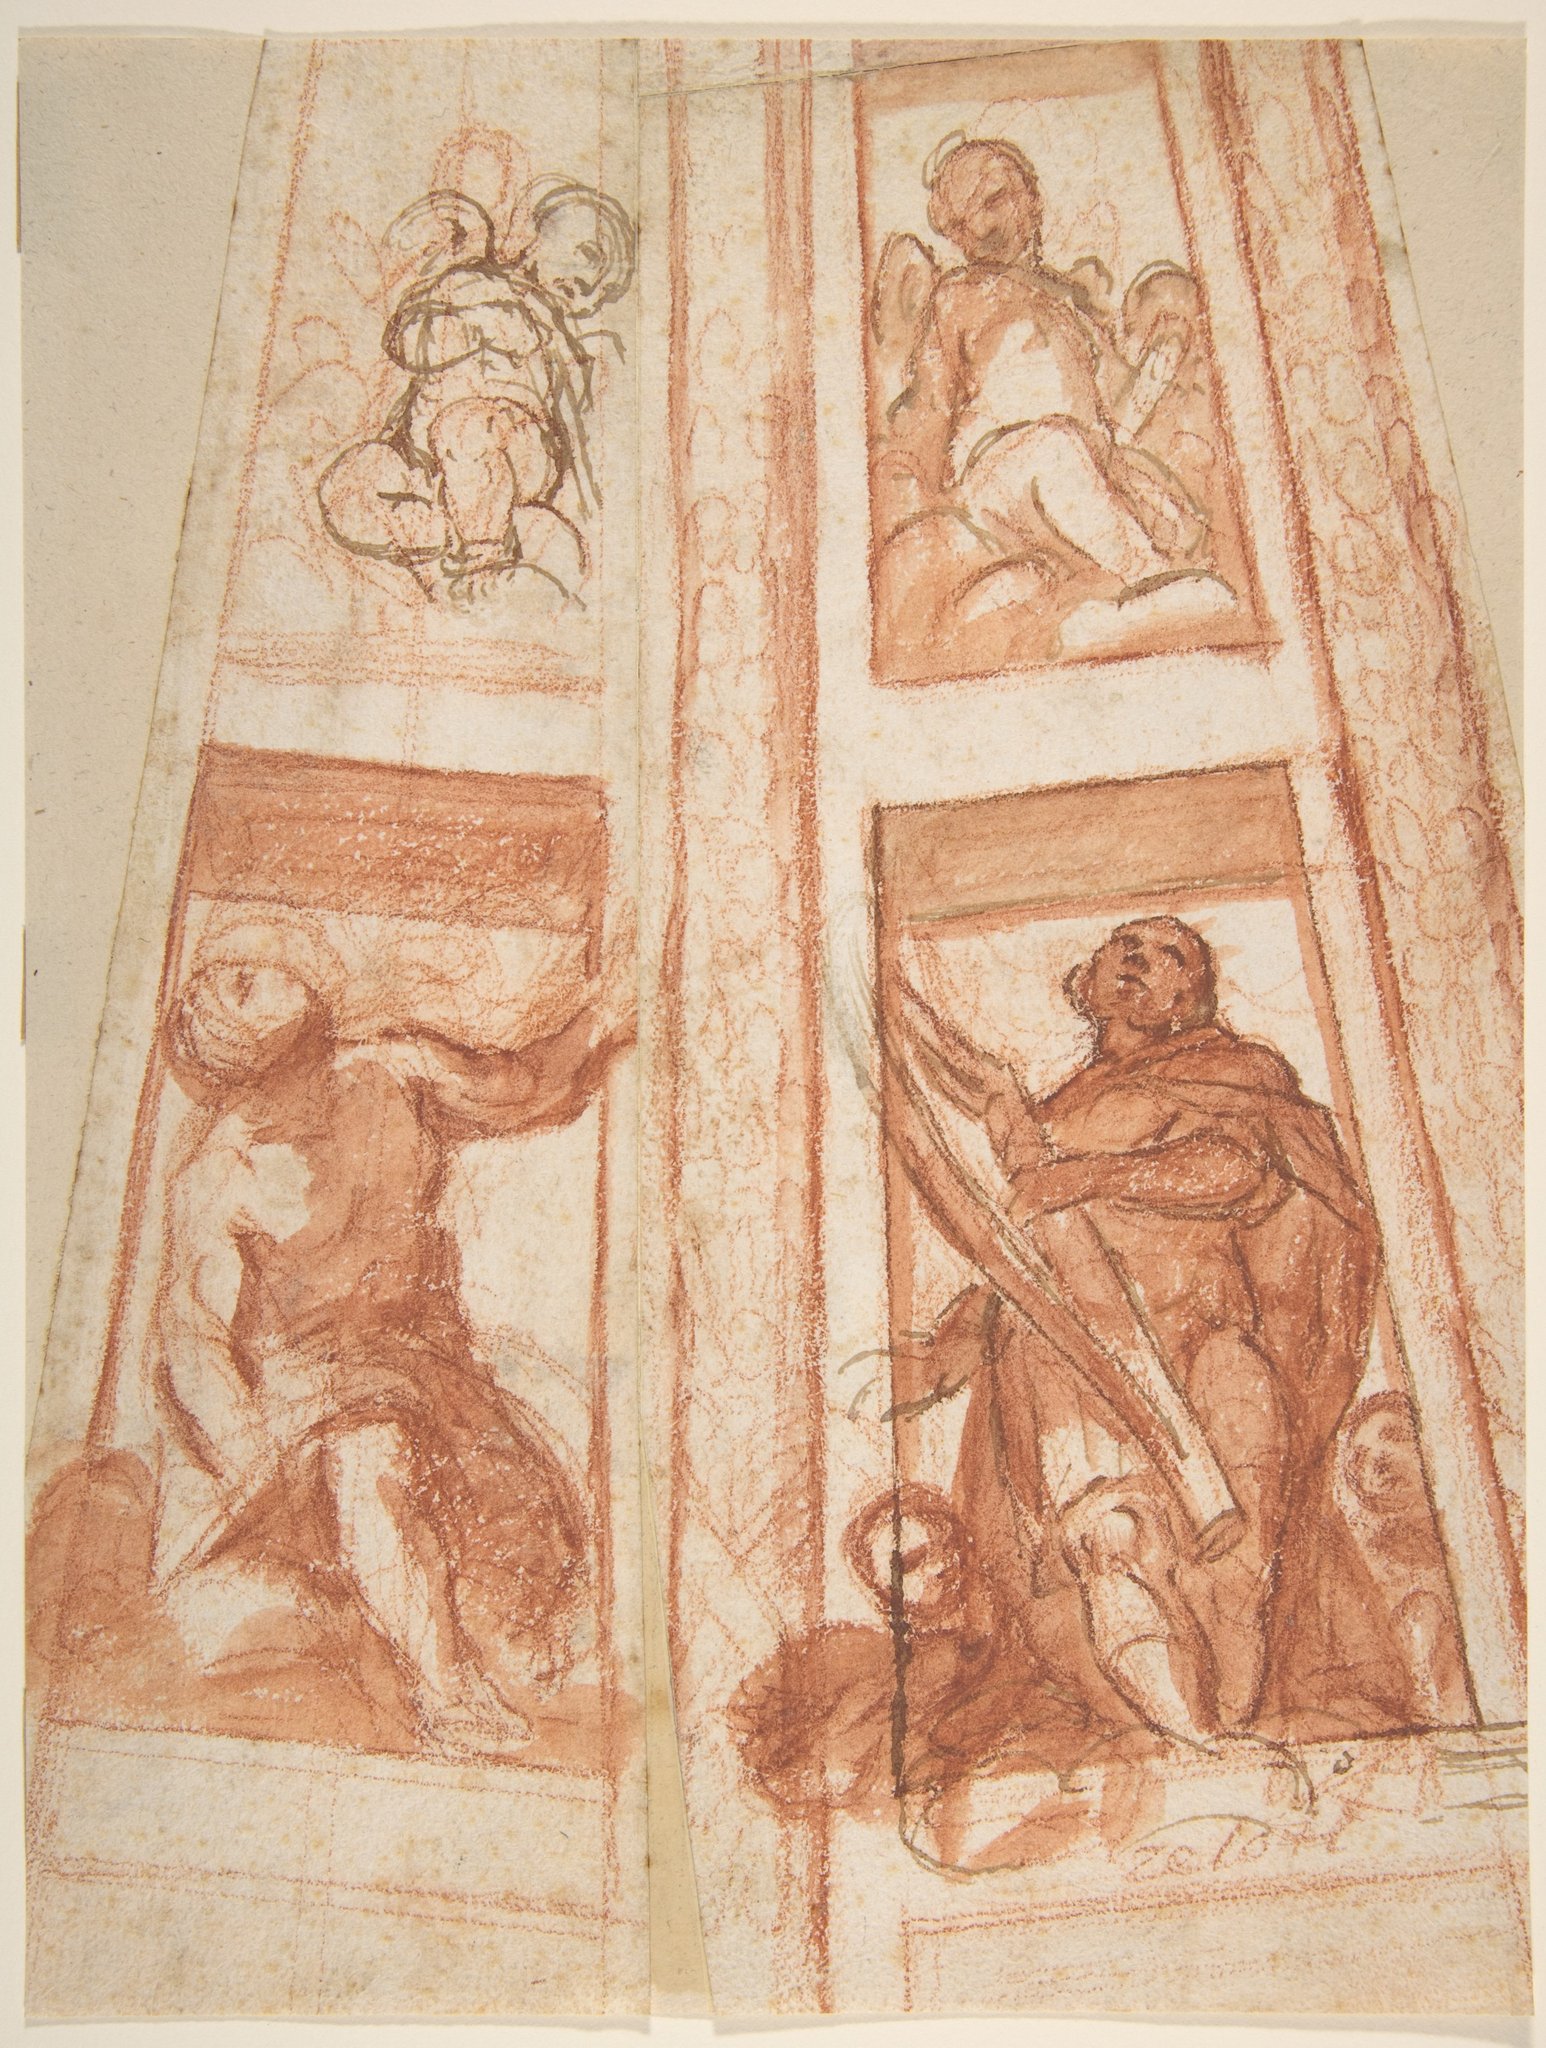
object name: drawing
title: Design for the Decoration of a Cupola with a Prophet, King David and Two Putti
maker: mattia preti (il cavalier calabrese)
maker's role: artist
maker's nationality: italian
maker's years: 1613-1699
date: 1613-1699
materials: chalk, ink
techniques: brush, pen, wash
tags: kings